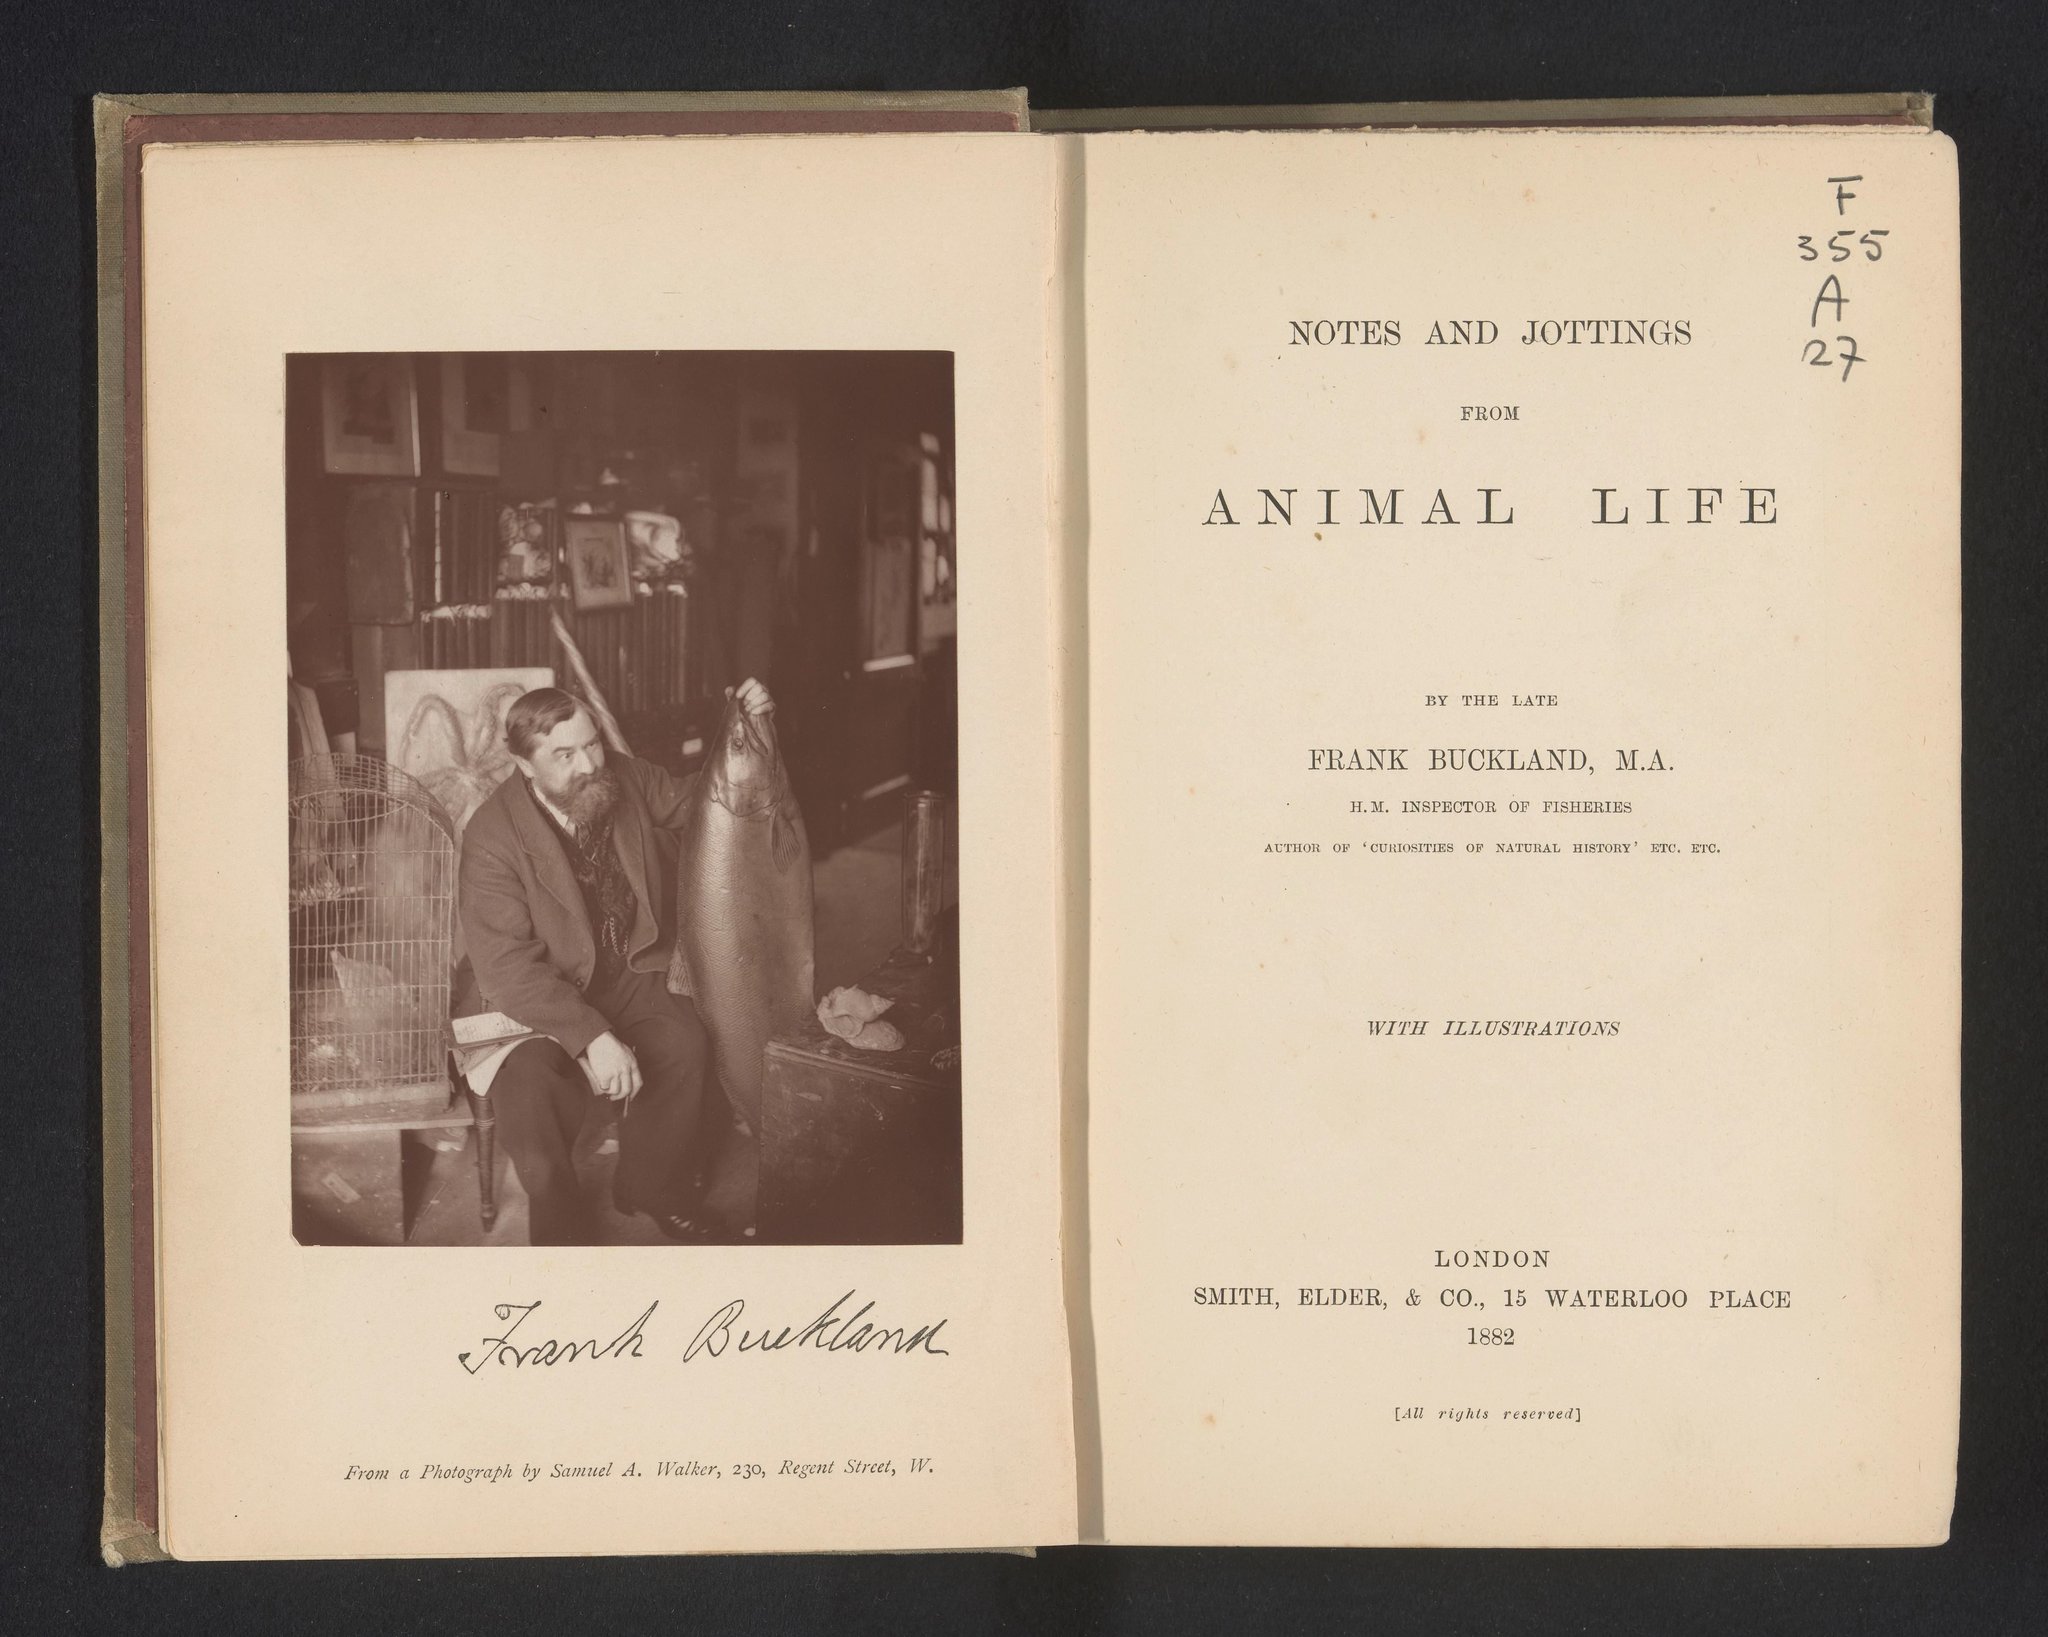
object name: book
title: Notes and jottings from animal life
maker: frank buckland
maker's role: schrijver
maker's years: 1826-1880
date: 1882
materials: cardboard, linen, paper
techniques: printing, woodburytype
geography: london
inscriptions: name: ‘C. Swaddell [...] 22/6/82’, inscription: ‘Sir Warwick Morshead Bart’